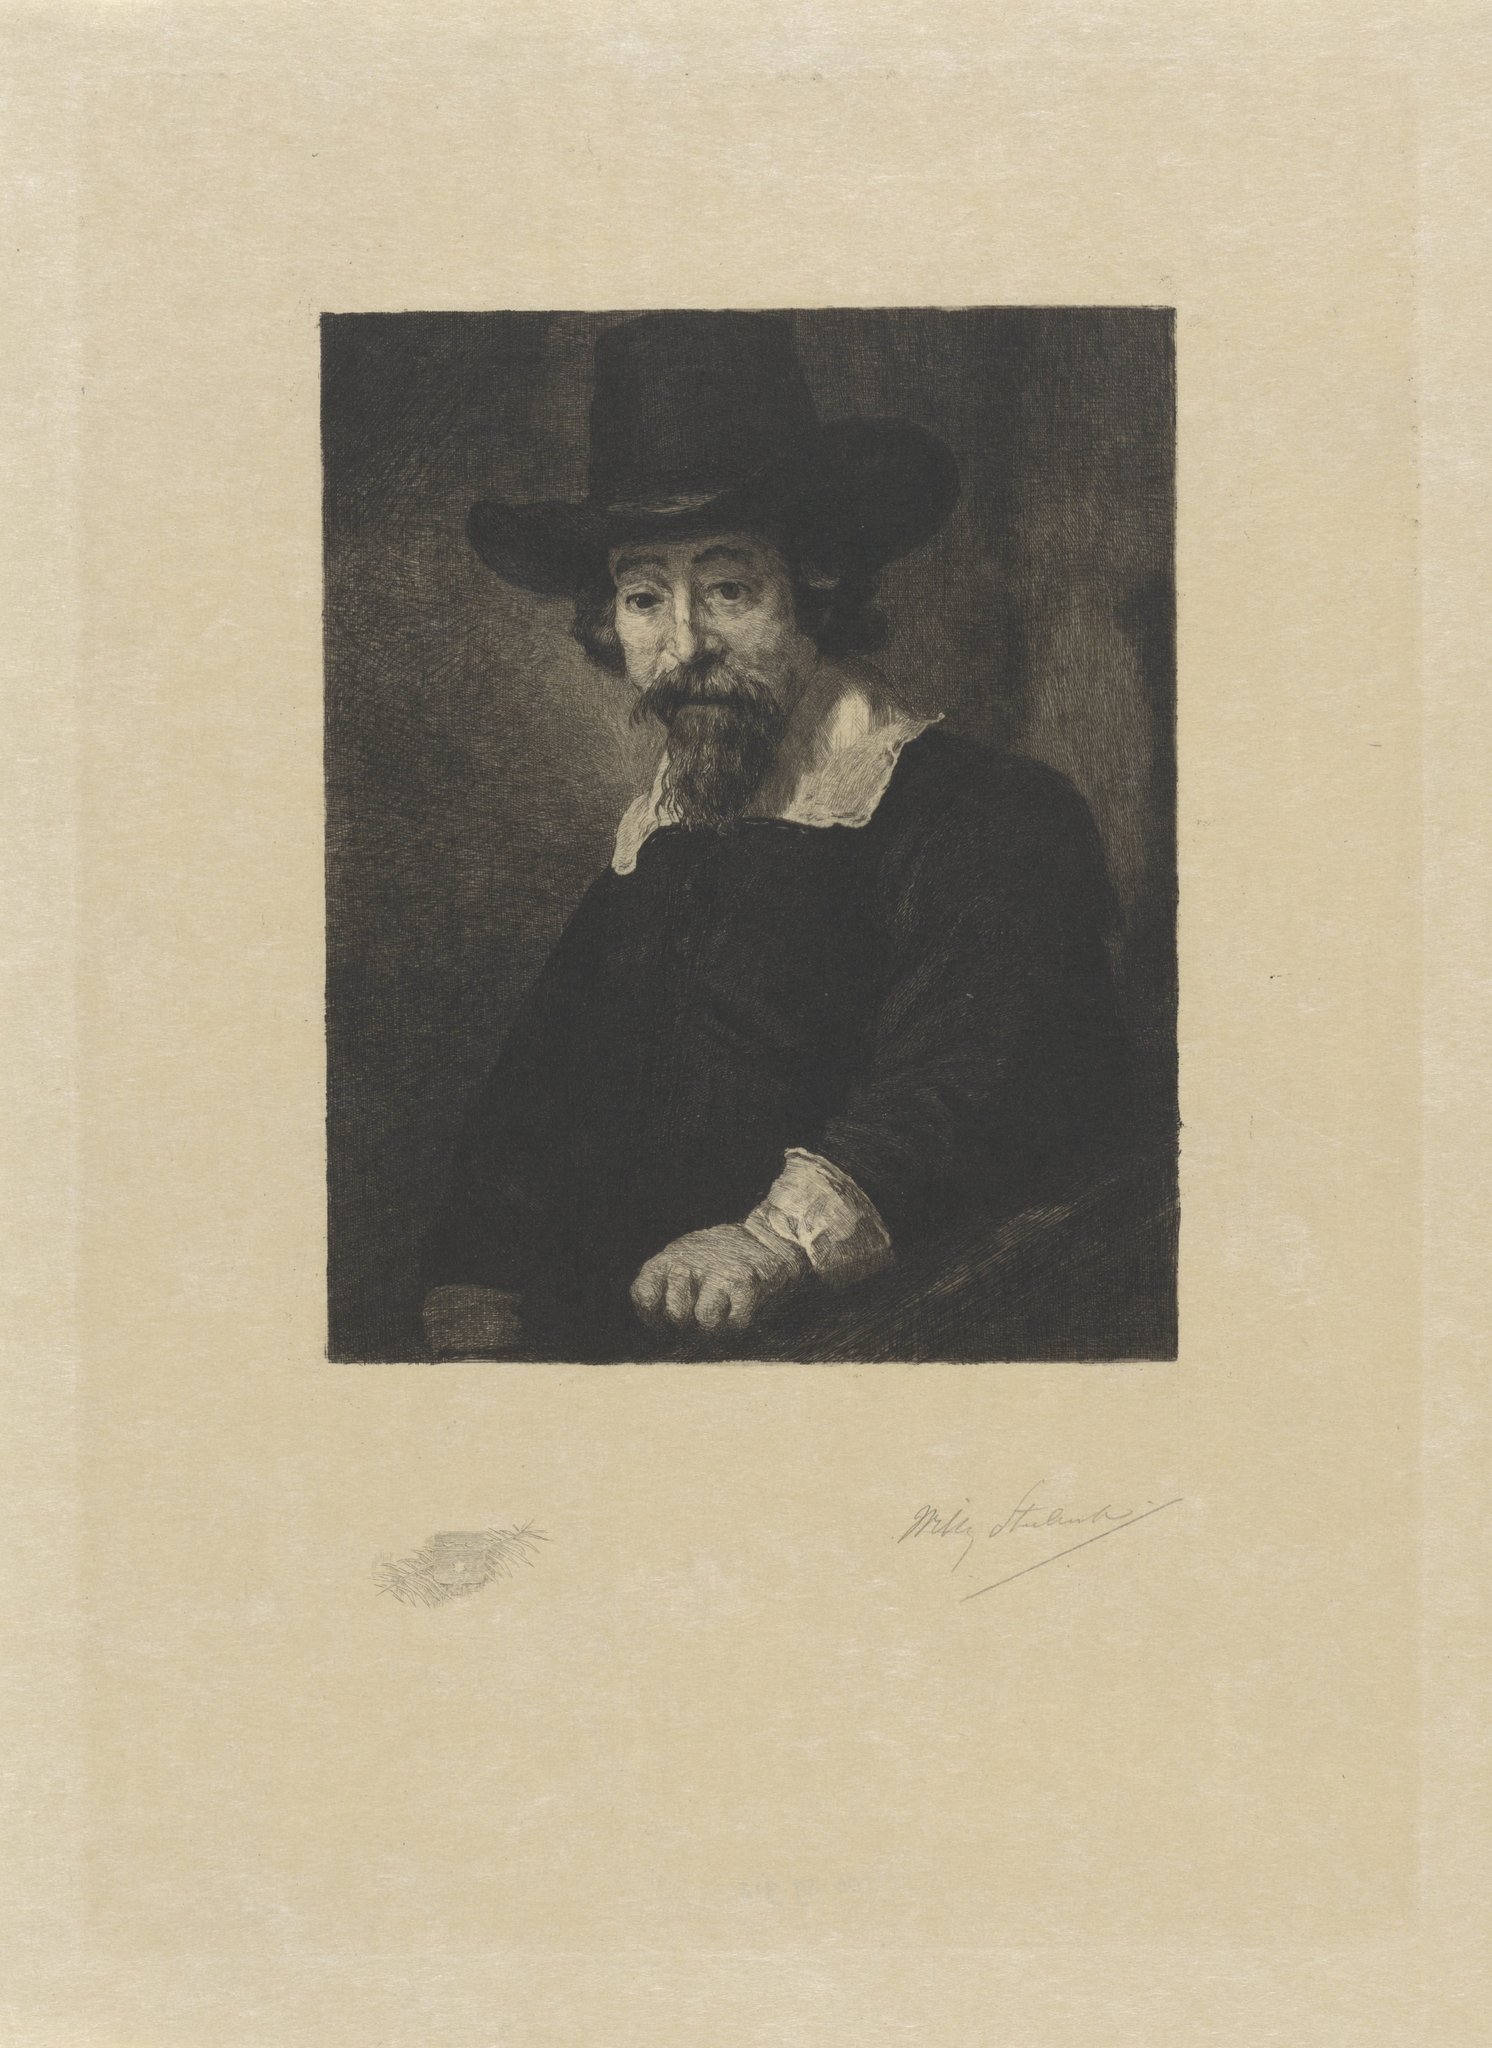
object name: print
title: Portret van een man, vermoedelijk Dr. Ephraim Hezekiah Bueno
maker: willem steelink (ii)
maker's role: draughtsman, print maker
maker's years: 1856-1928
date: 1888-1891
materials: paper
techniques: etching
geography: netherlands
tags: historical persons, head-gear: hat (+ men's clothes), physician, doctor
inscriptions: collector's mark: Lugt 2228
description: Portret van een man, vermoedelijk Dr. Ephraim Hezekiah Bueno (1599-1665), Joods geneesheer en letterkundige te Amsterdam. Ten halven lijve, staande en leunend met de linkerhand op de leuning van een trap. Op het hoofd een hoge zwart hoed. Linksonder in de marge een wapenschild op een takje met bladeren.